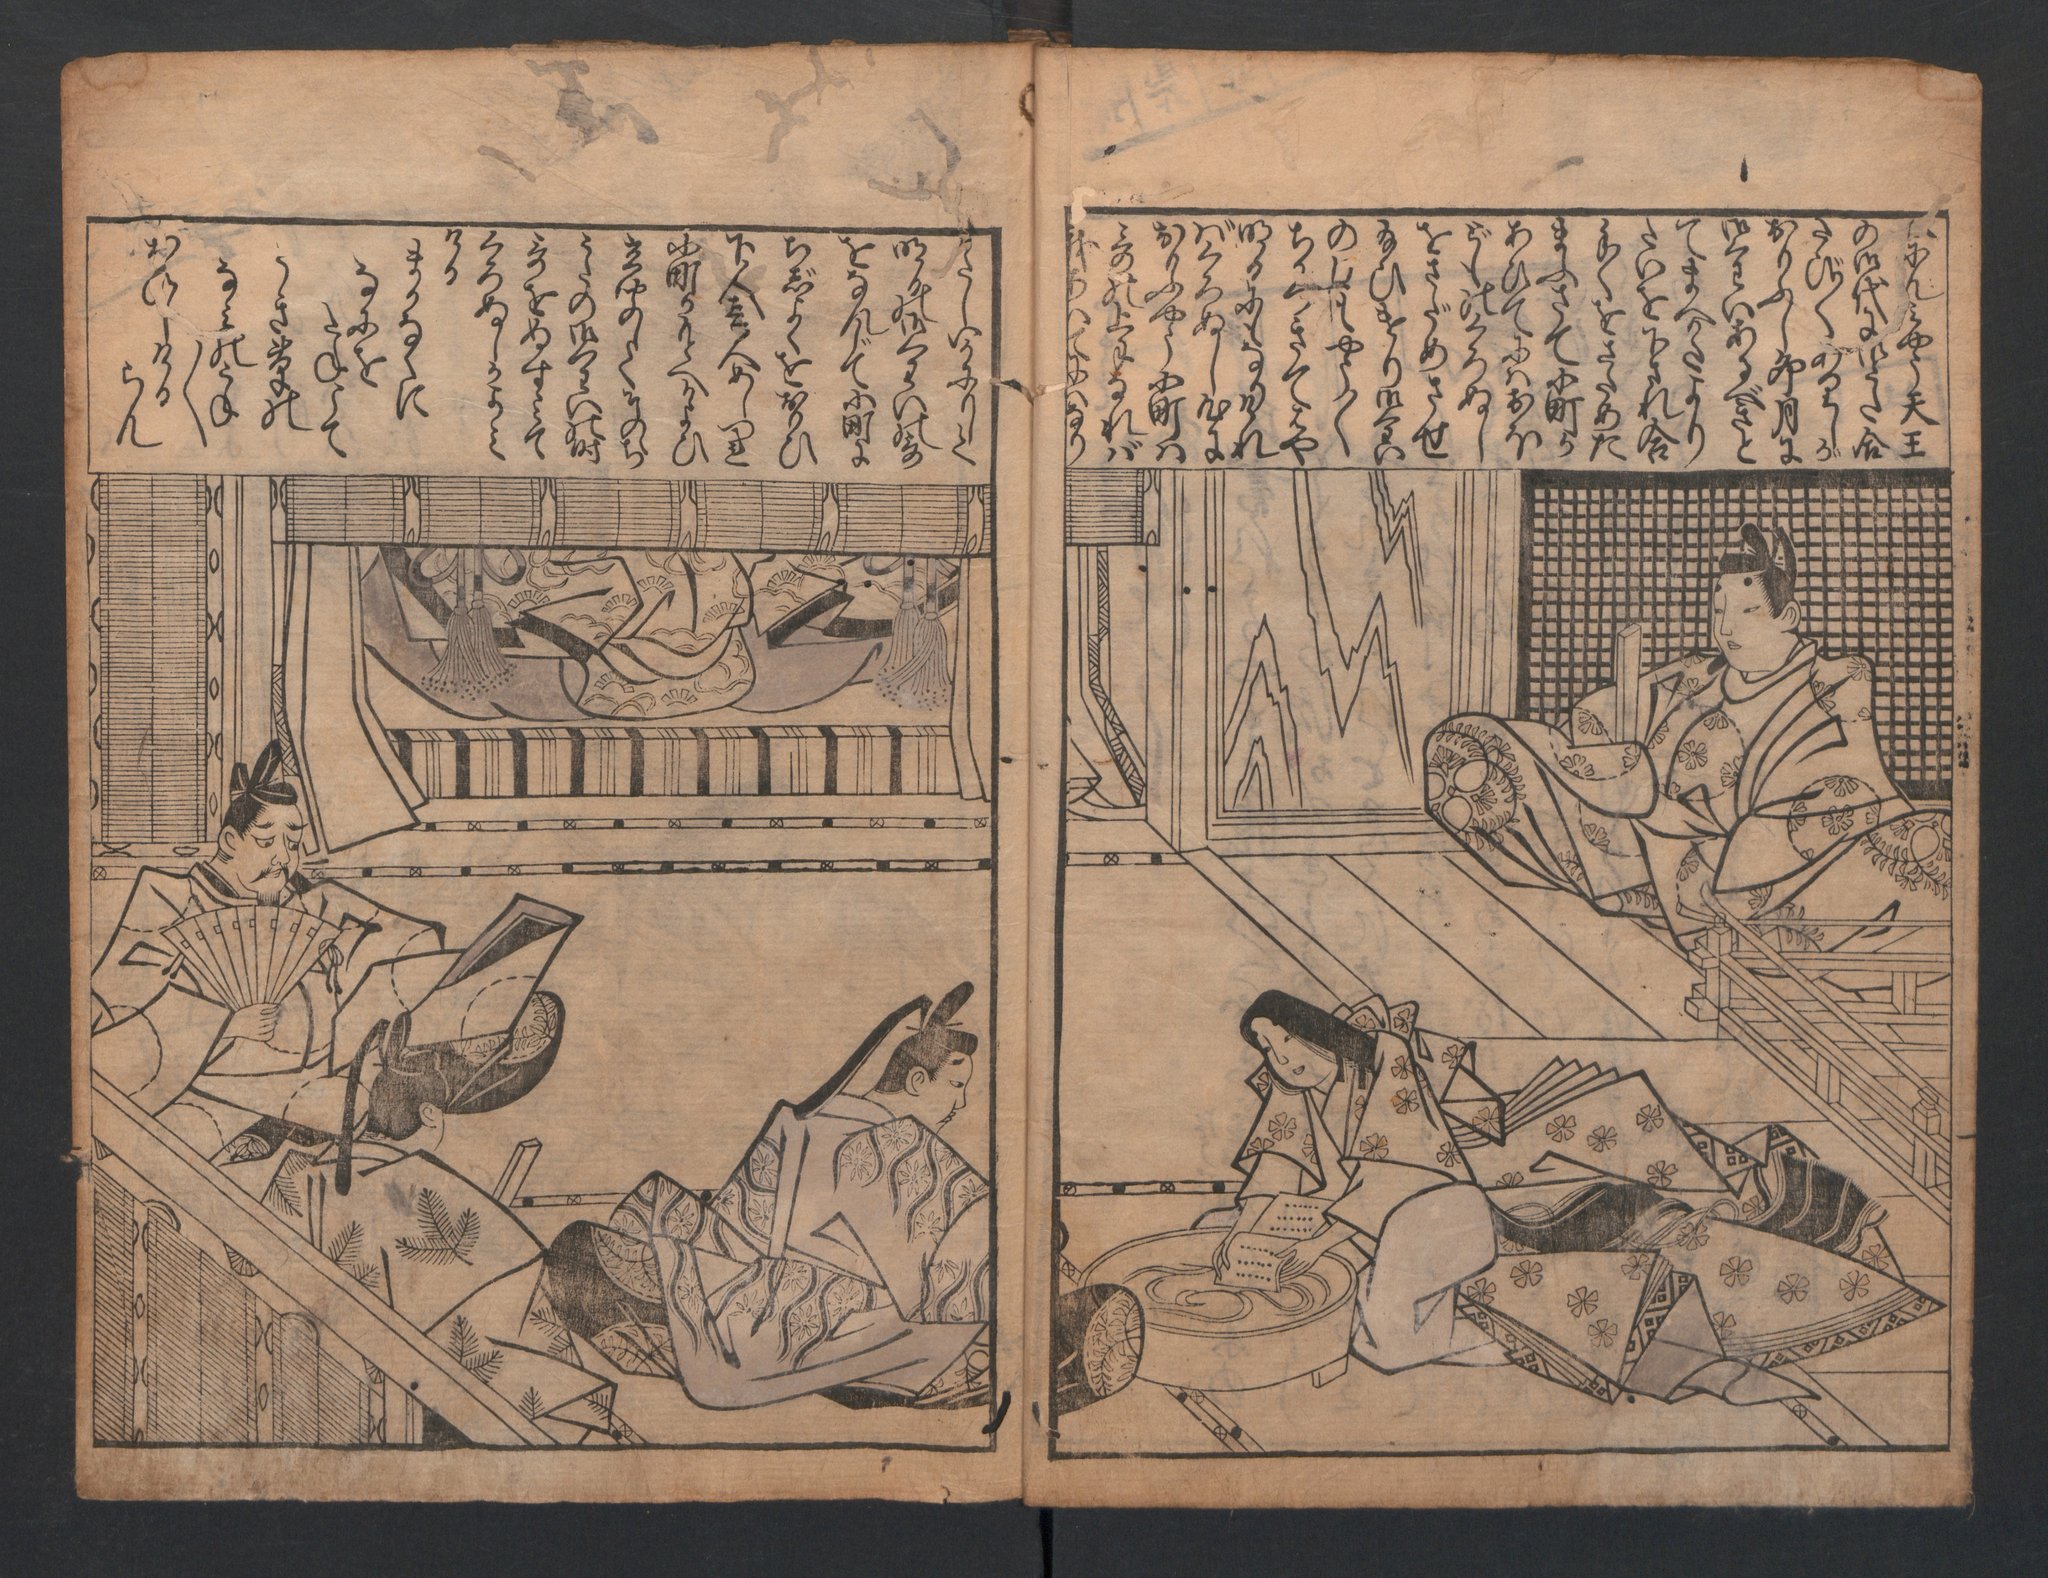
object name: illustrated book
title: Illustrations of Japanese Painting Themes (Yamato-e zukushi) 大和絵づくし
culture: japanese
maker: hishikawa moronobu 菱川師宣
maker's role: artist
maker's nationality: japanese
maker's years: 1618-1694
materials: ink, paper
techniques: woodblock print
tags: men,women